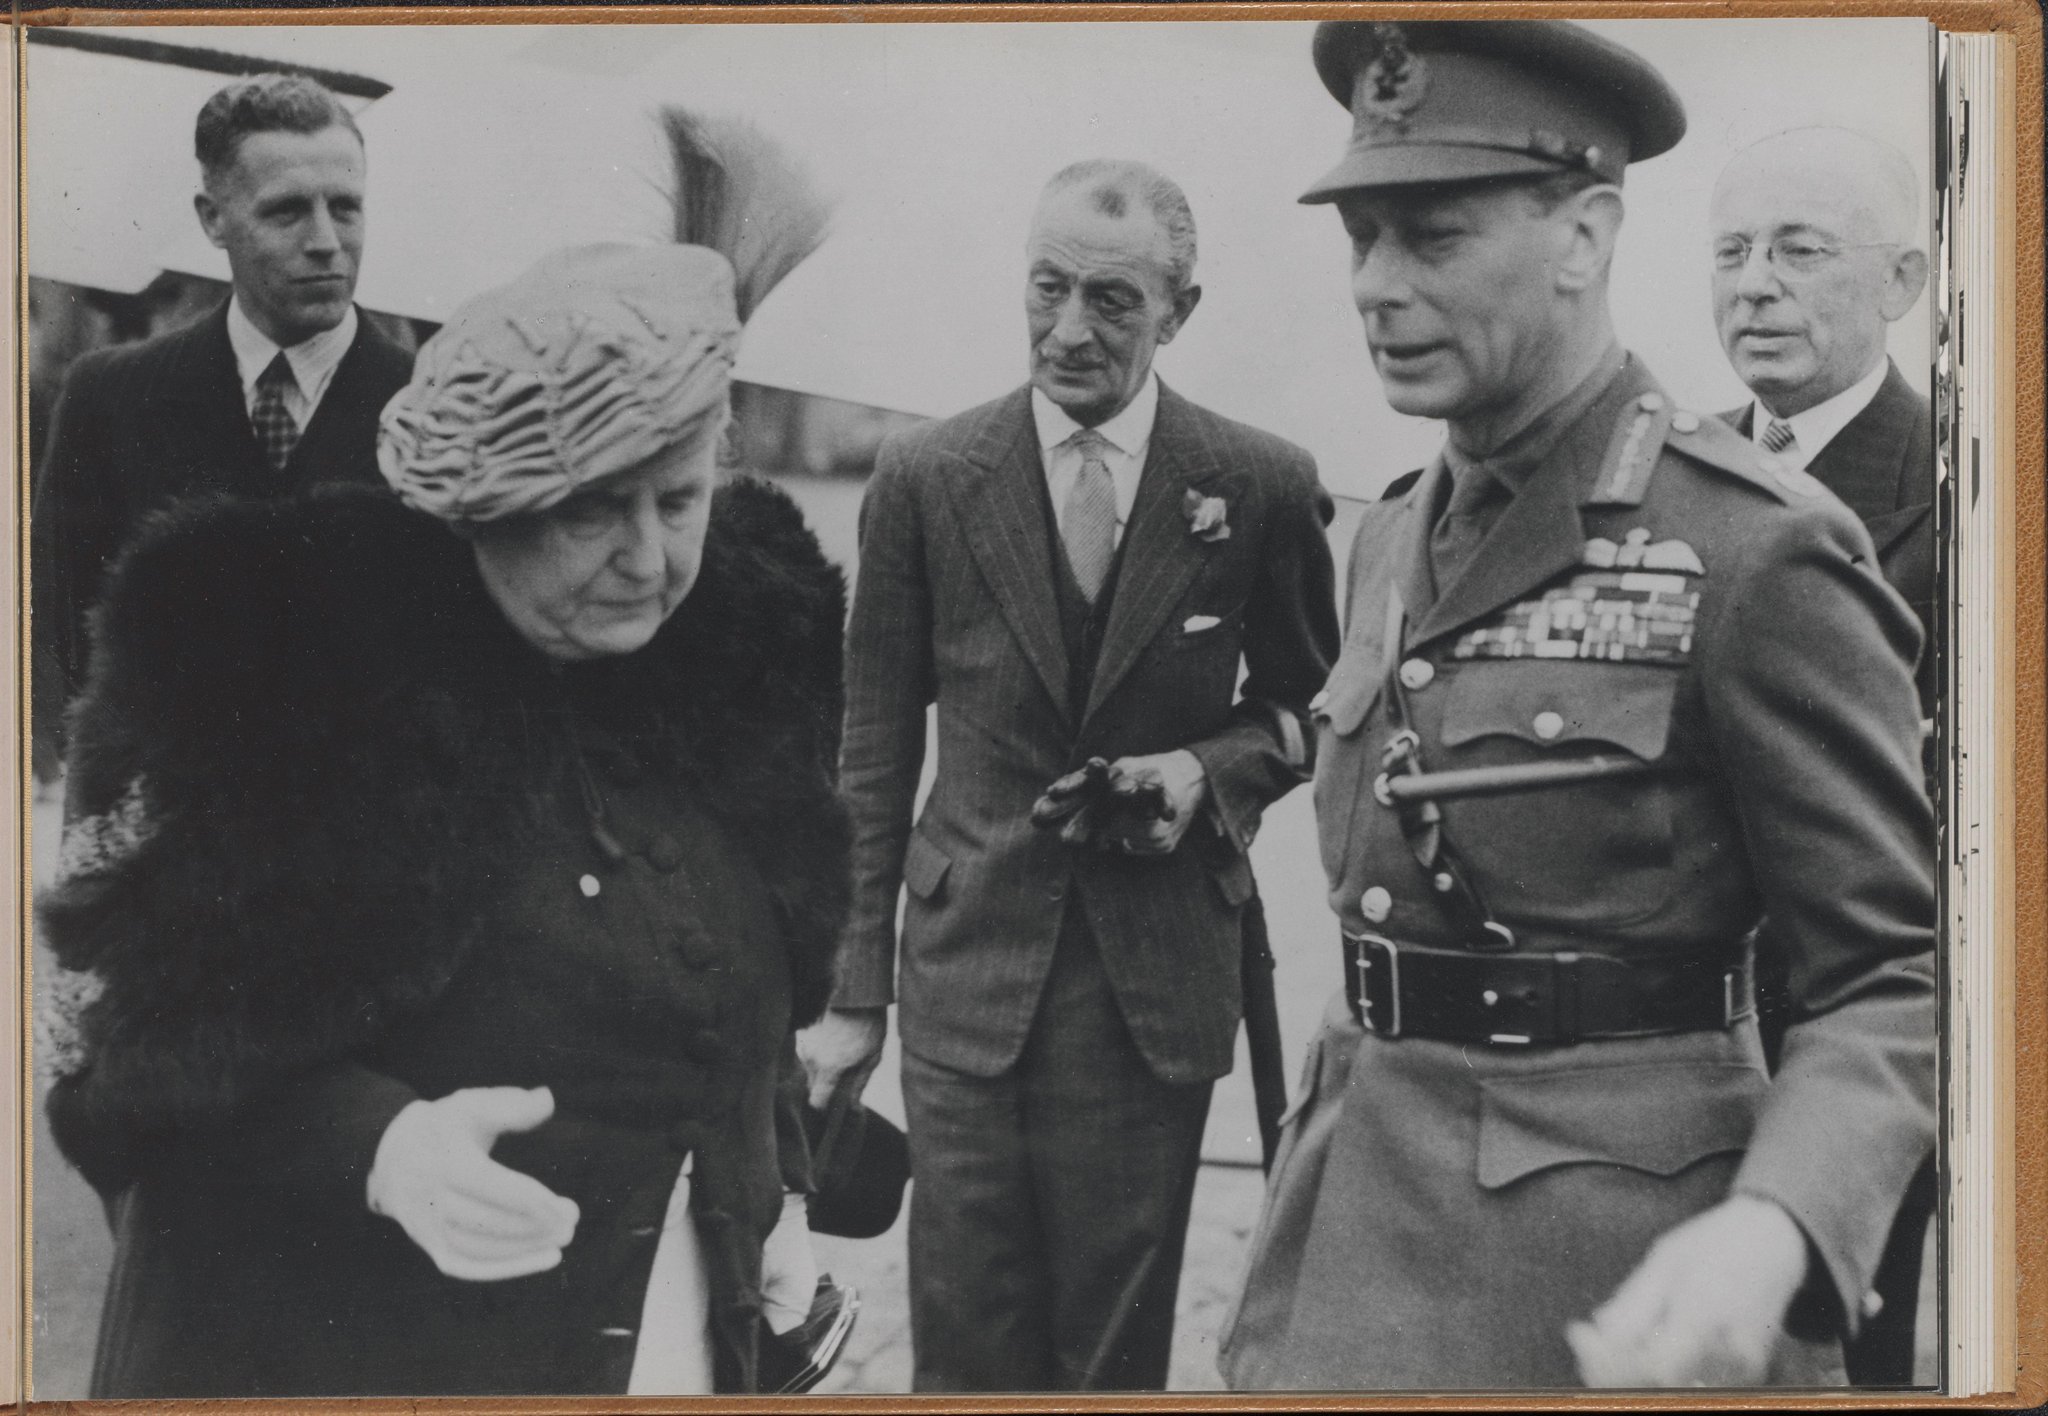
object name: album leaf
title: Koningin Wilhelmina en de Britse koning George VI op Croydon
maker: Anonymous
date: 1908-1946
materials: cardboard, paper, photographic support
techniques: gelatin silver print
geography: london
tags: print maker, wilhelmina of the netherlands, leiden, the hague, airborne traffic, aviation, airfield, airport, arrival and return ~ travelling, travelling; tourism, london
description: Albumblad met een foto van de Britse koning George VI (vooraan rechts) die koningin Wilhelmina uitgeleide doet op de Londense luchthaven Croydon. Rechts achteraan Hans Martin, de grondlegger van de Indië-lijn van de KLM. Onderdeel van Herdenkingsalbum van de Indië-lijn van de KLM, deel II.